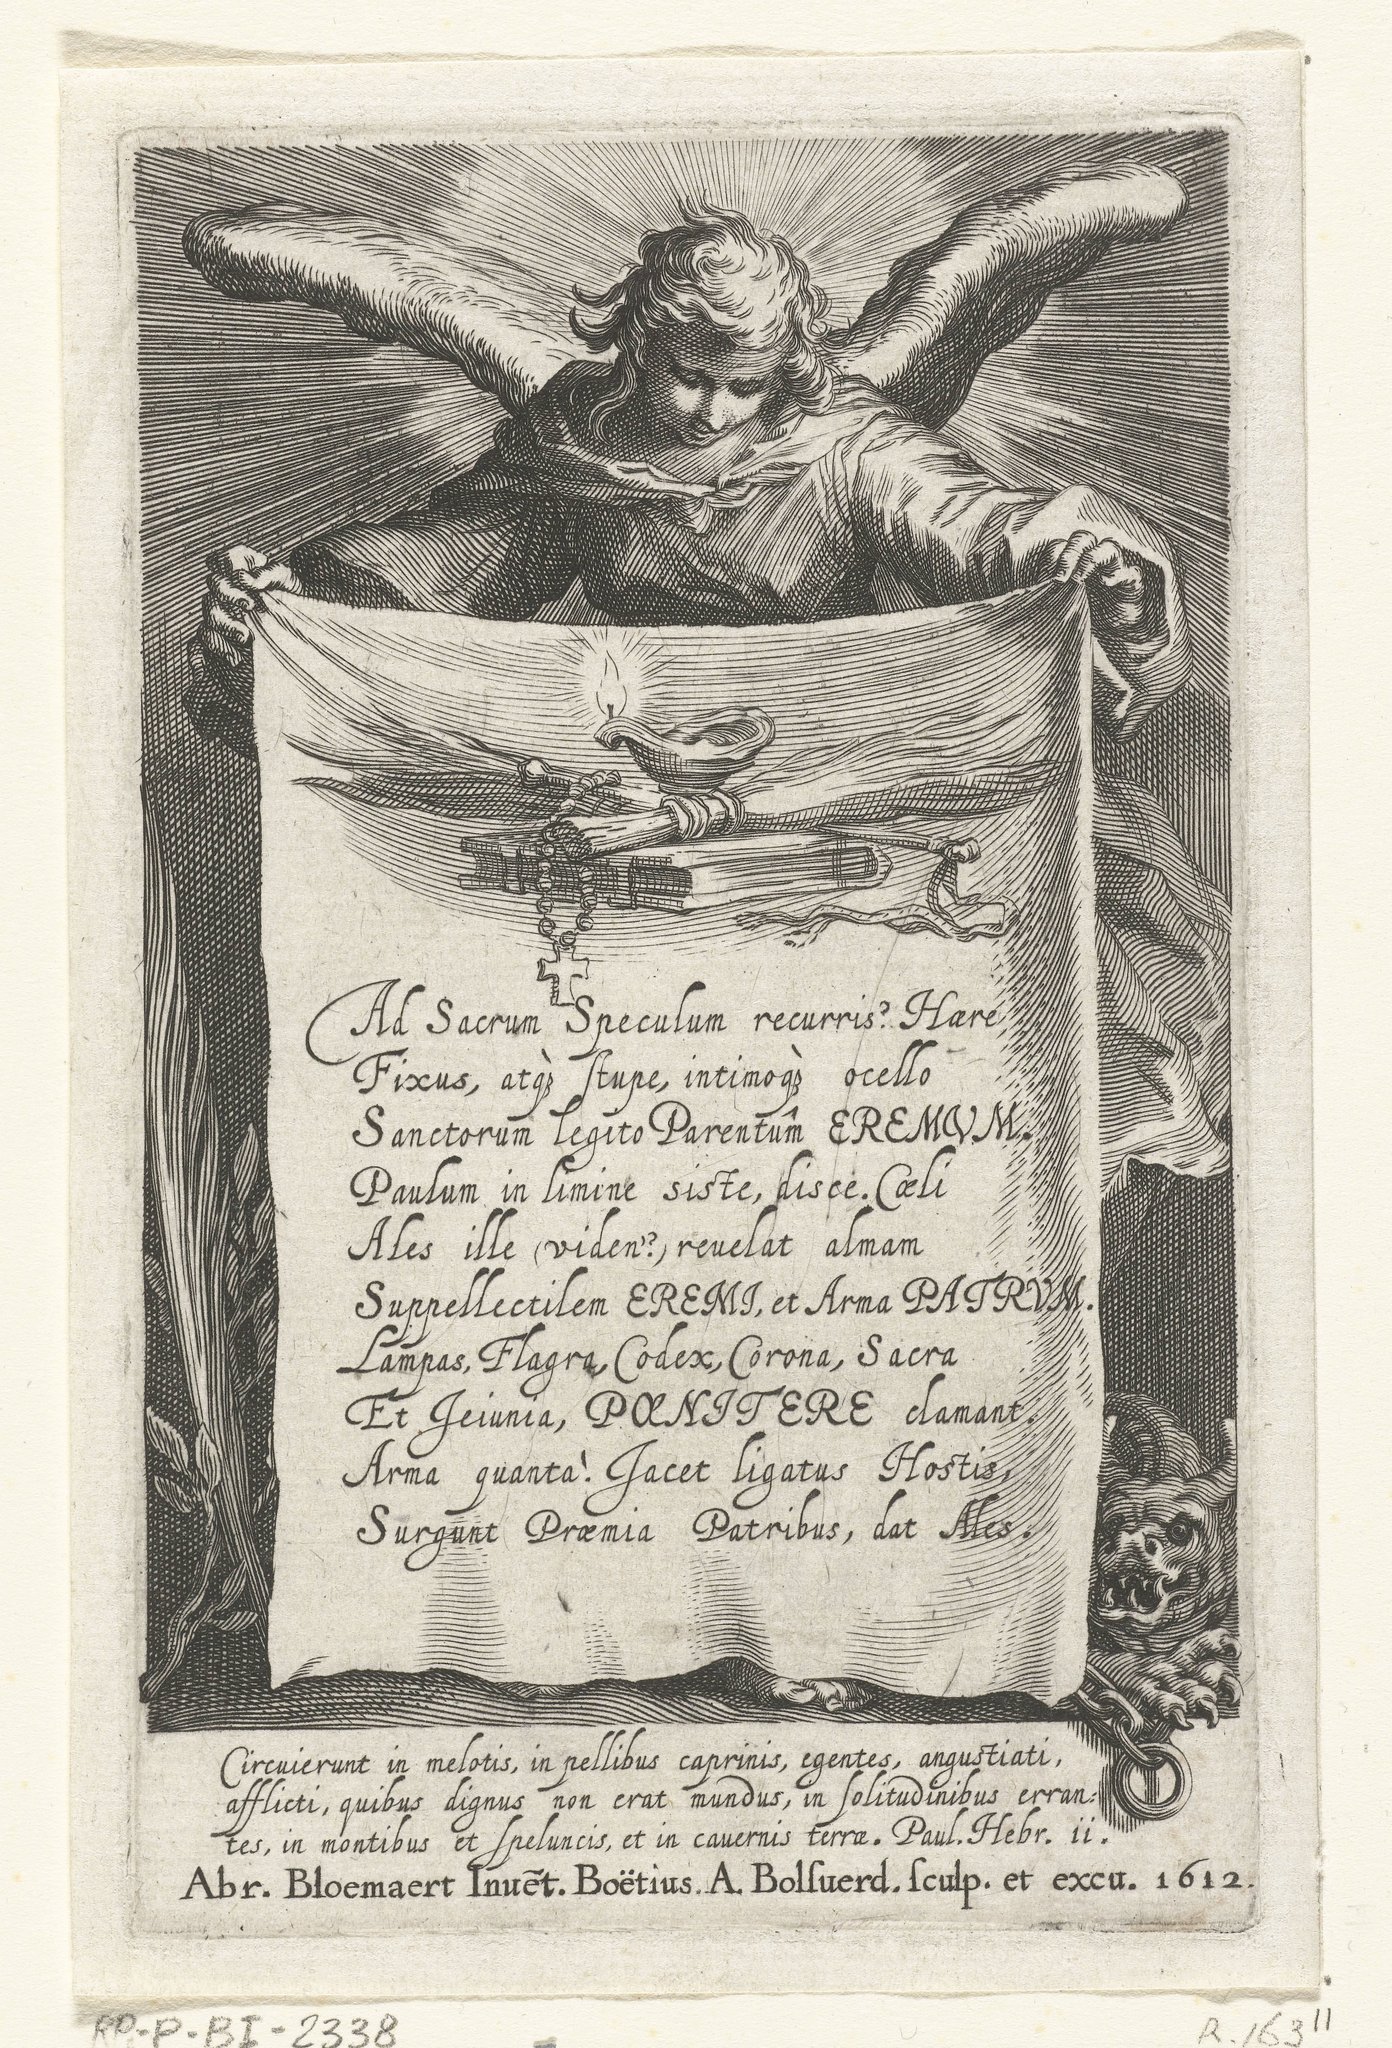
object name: print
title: Ad sacrum speculum (...) patribus dat ales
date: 1590-1612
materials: paper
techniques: engraving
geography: low countries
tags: aids for prayer, e.g. rosary, ascetic life and practice, angels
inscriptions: collector's mark: Lugt 240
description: Titelpagina voor: Ad sacrum speculum recurris? ... patribus dat ales, geen plaats, Boëtius Adamsz. Bolswert, 1612. Tweede ongebonden uitgave met in totaal vijftig prenten. Dit is de titelpagina bij de serie van drieentwintig mannelijke kluizenaars. In 1619 verscheen een gebonden editie maar op basis van de gewijzigde opschriften en samenstelling wordt aangenomen dat deze prenten ook in 1612 of iets daarvoor gedrukt werden. Roethlisberger beschouwt de uitgave van 1619 als de eerste staat en de ongebonden editie van 1612 als de tweede staat (Roethlisberger 1993, p. 171, 172).